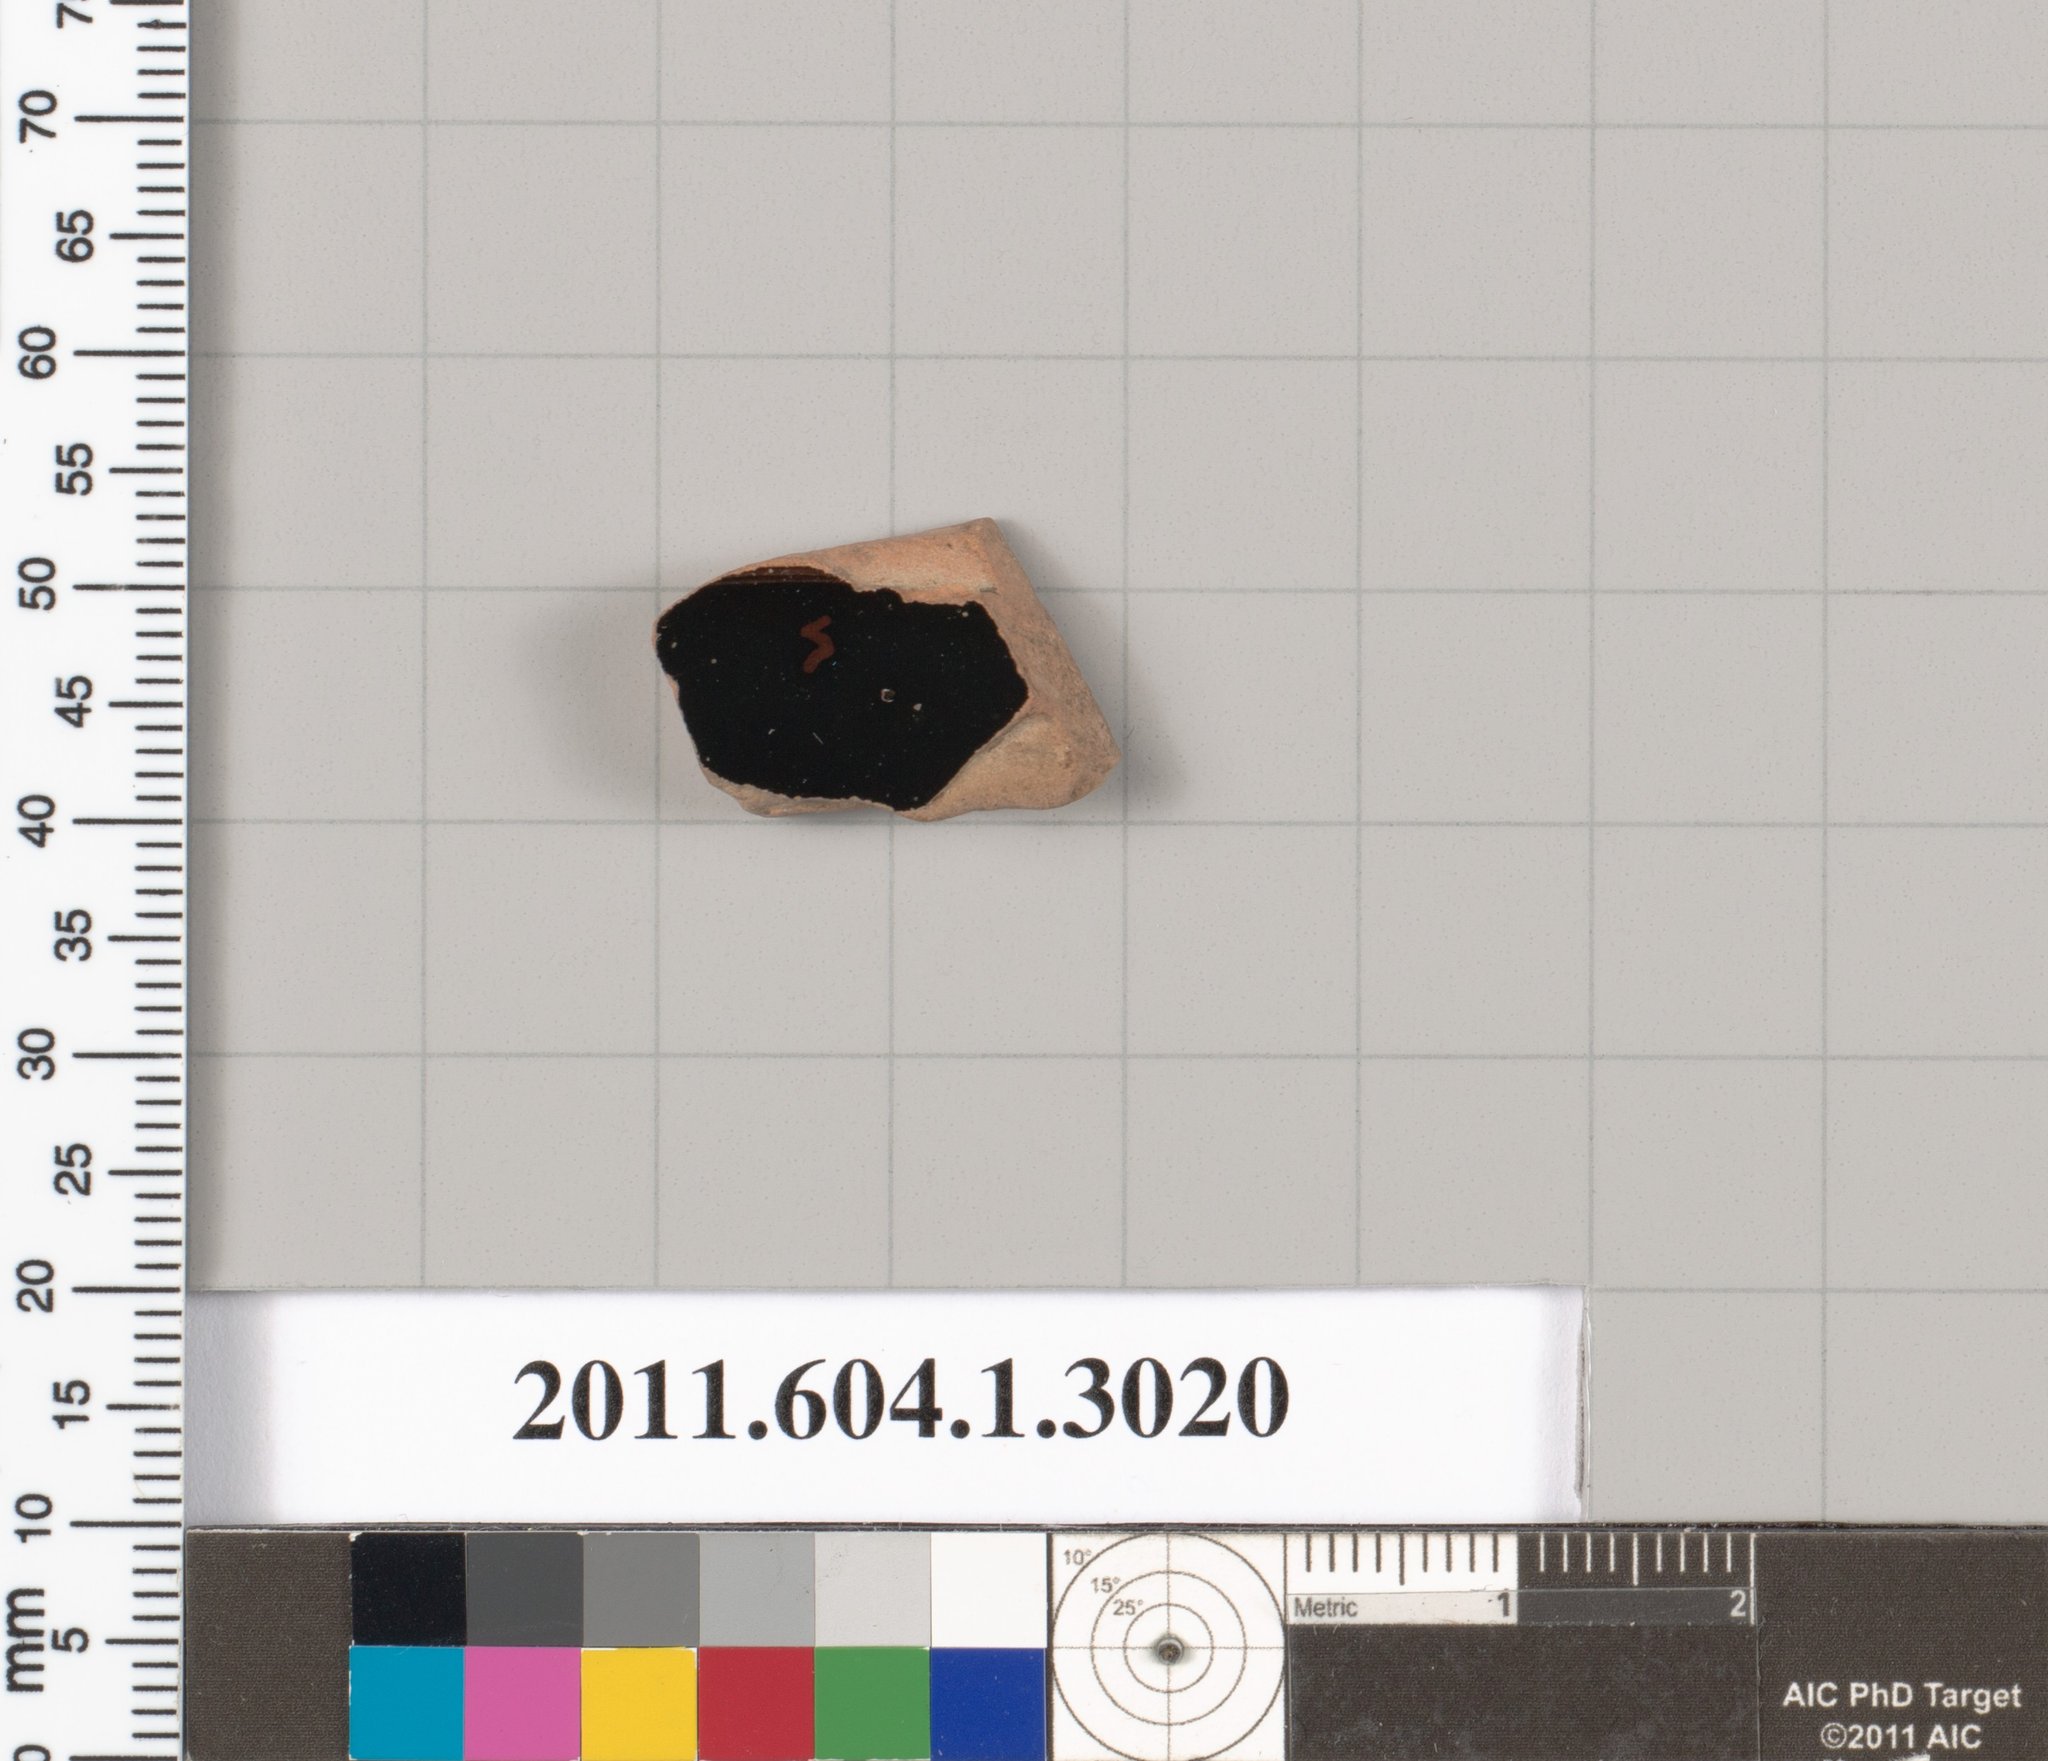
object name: kylix fragment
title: Terracotta fragment of a kylix (drinking cup)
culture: greek, attic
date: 500-480 BCE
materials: terracotta